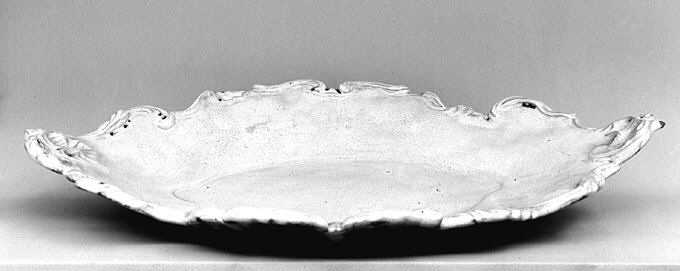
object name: plateau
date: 1701-1800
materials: faience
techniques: glazing